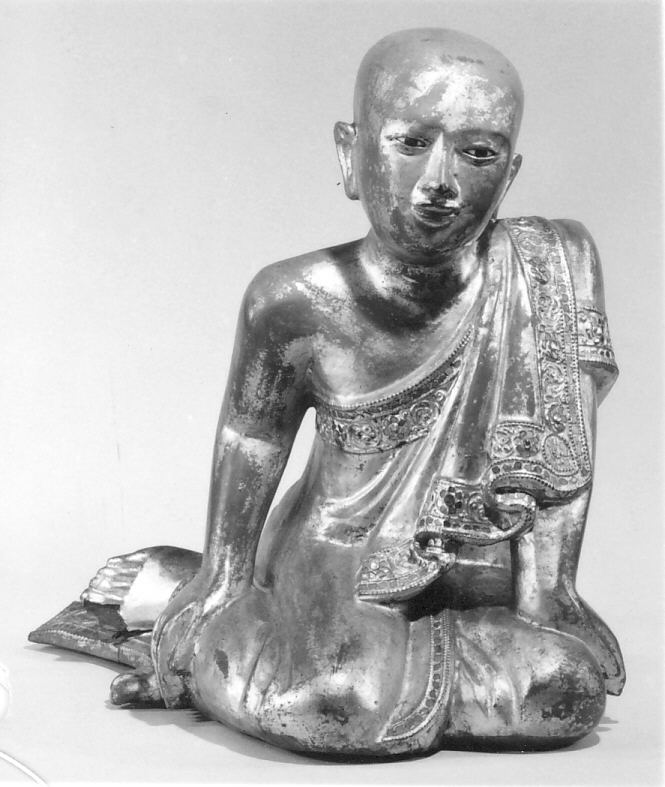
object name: figure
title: Seated Ananda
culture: burmese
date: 1701-1800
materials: gilt, glass, lacquer, wood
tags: men,buddhism